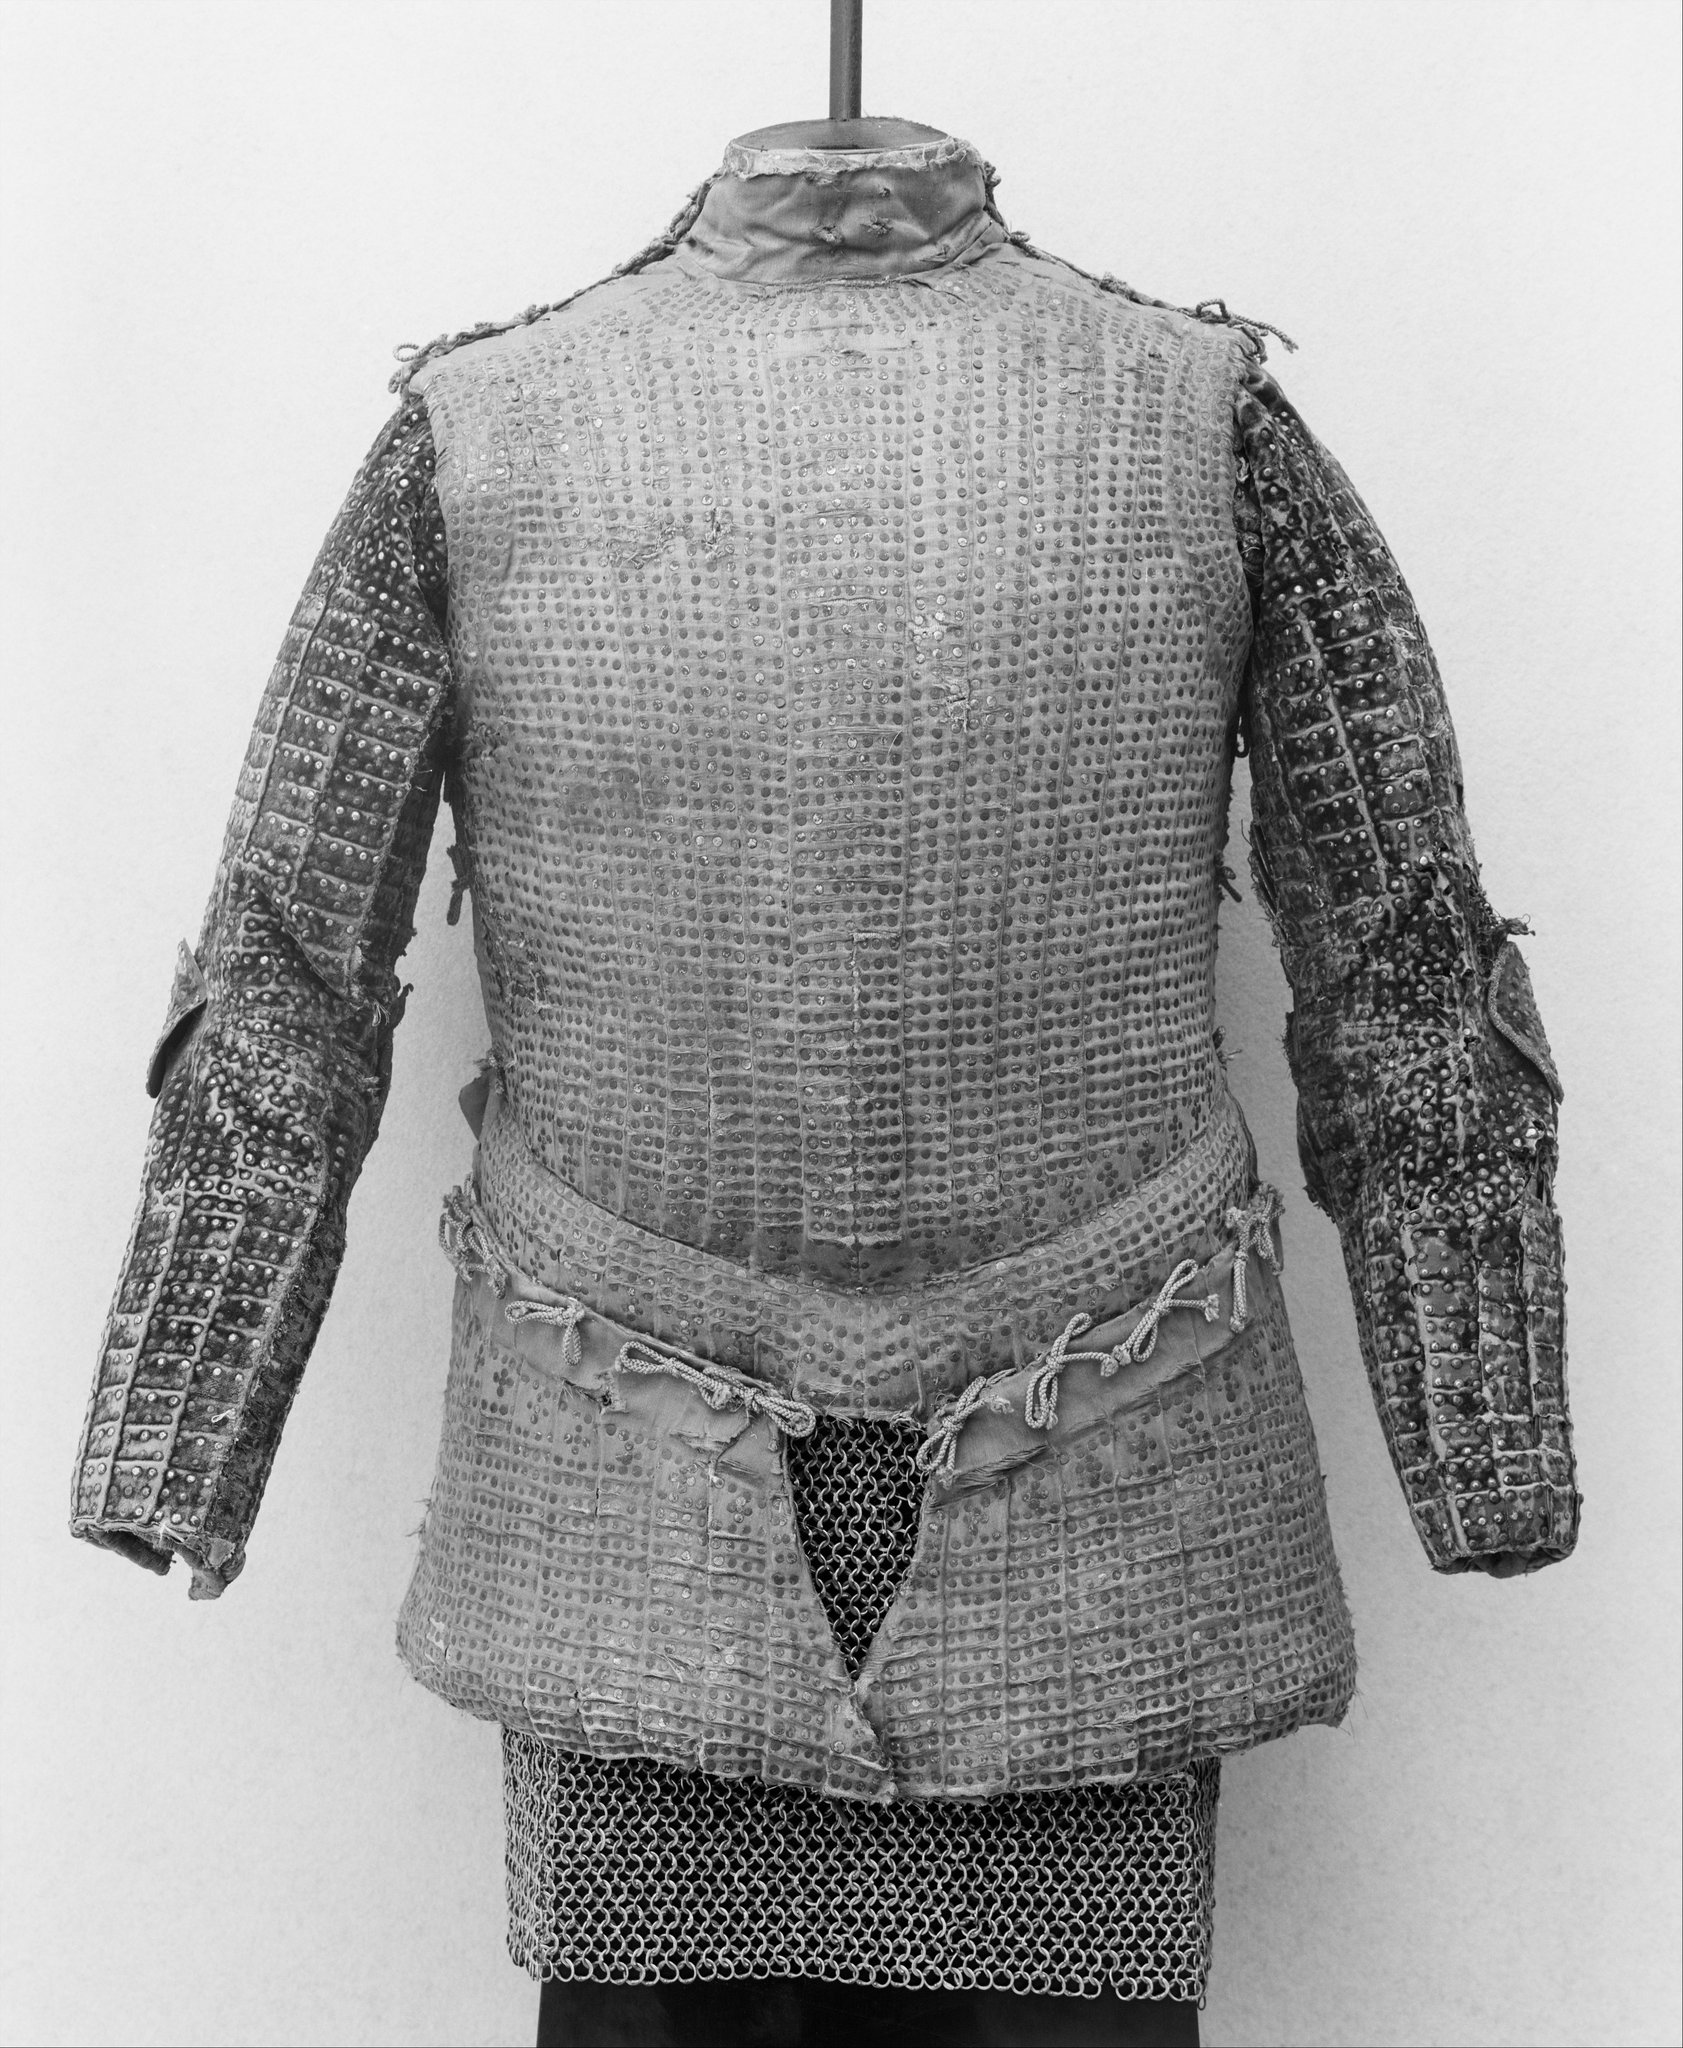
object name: brigandine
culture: italian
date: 1540-1550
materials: brass, gilt, iron, textile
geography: italy